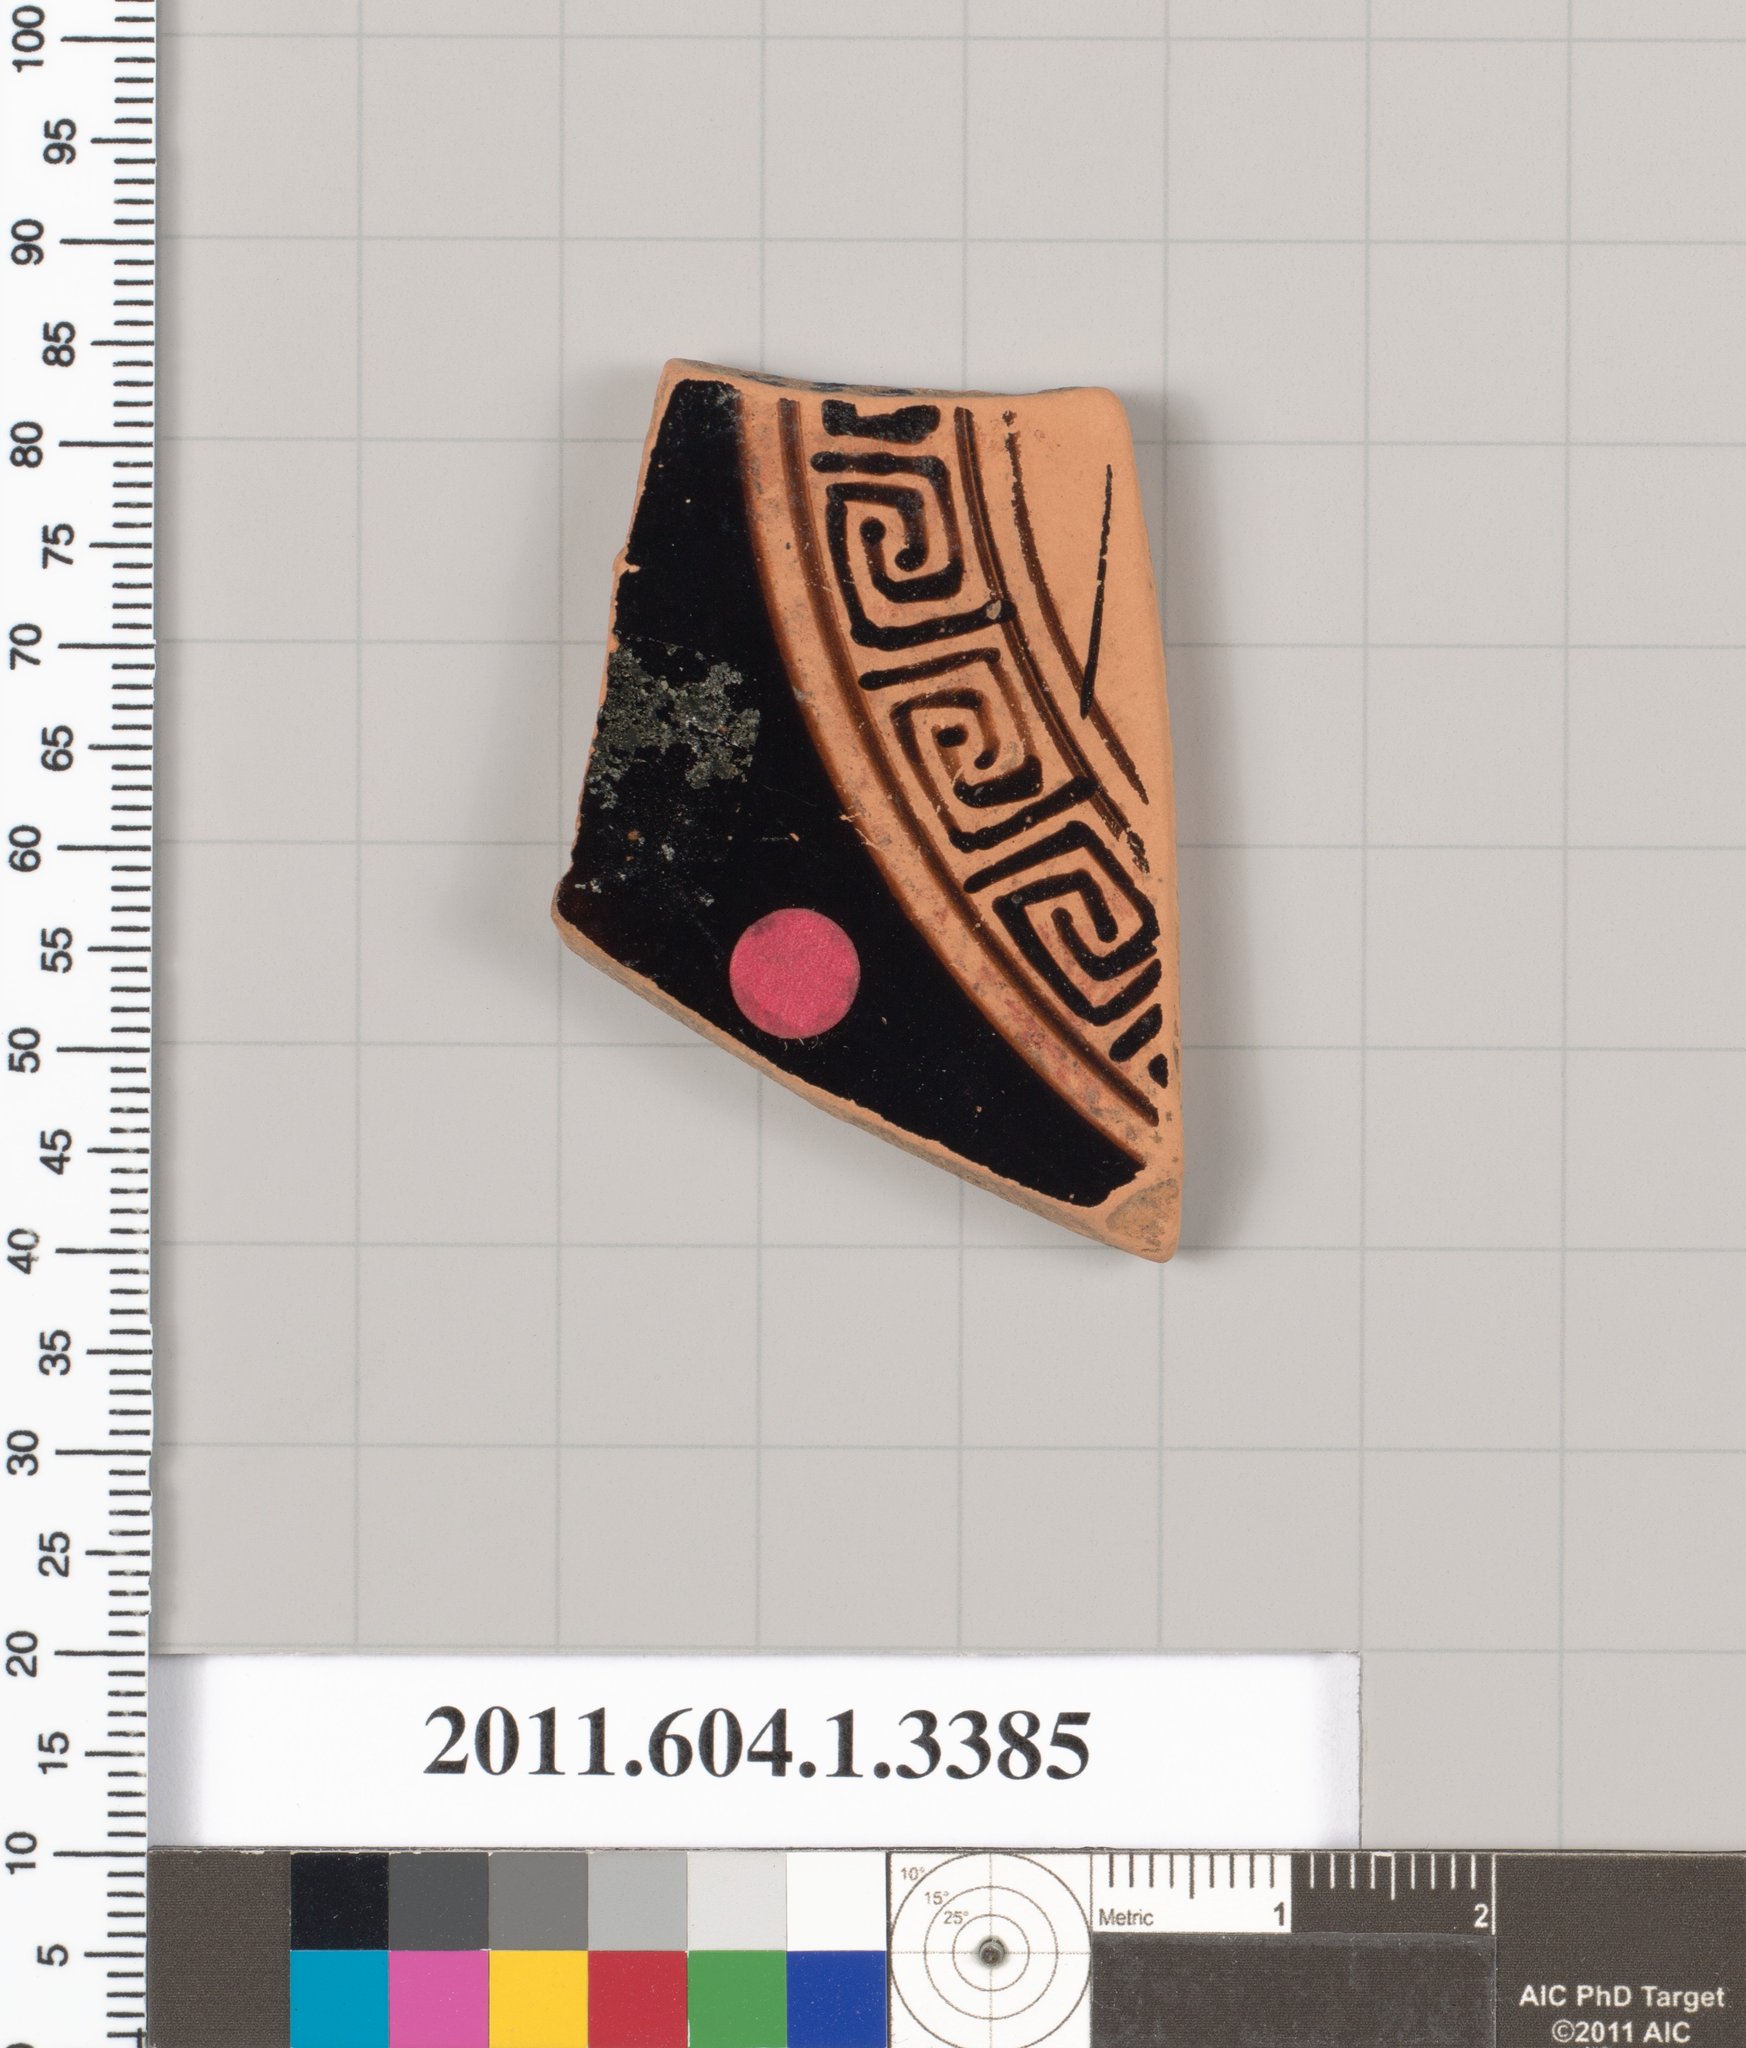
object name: kylix fragment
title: Terracotta fragment of a kylix (drinking cup)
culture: greek, attic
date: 475-451 BCE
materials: terracotta